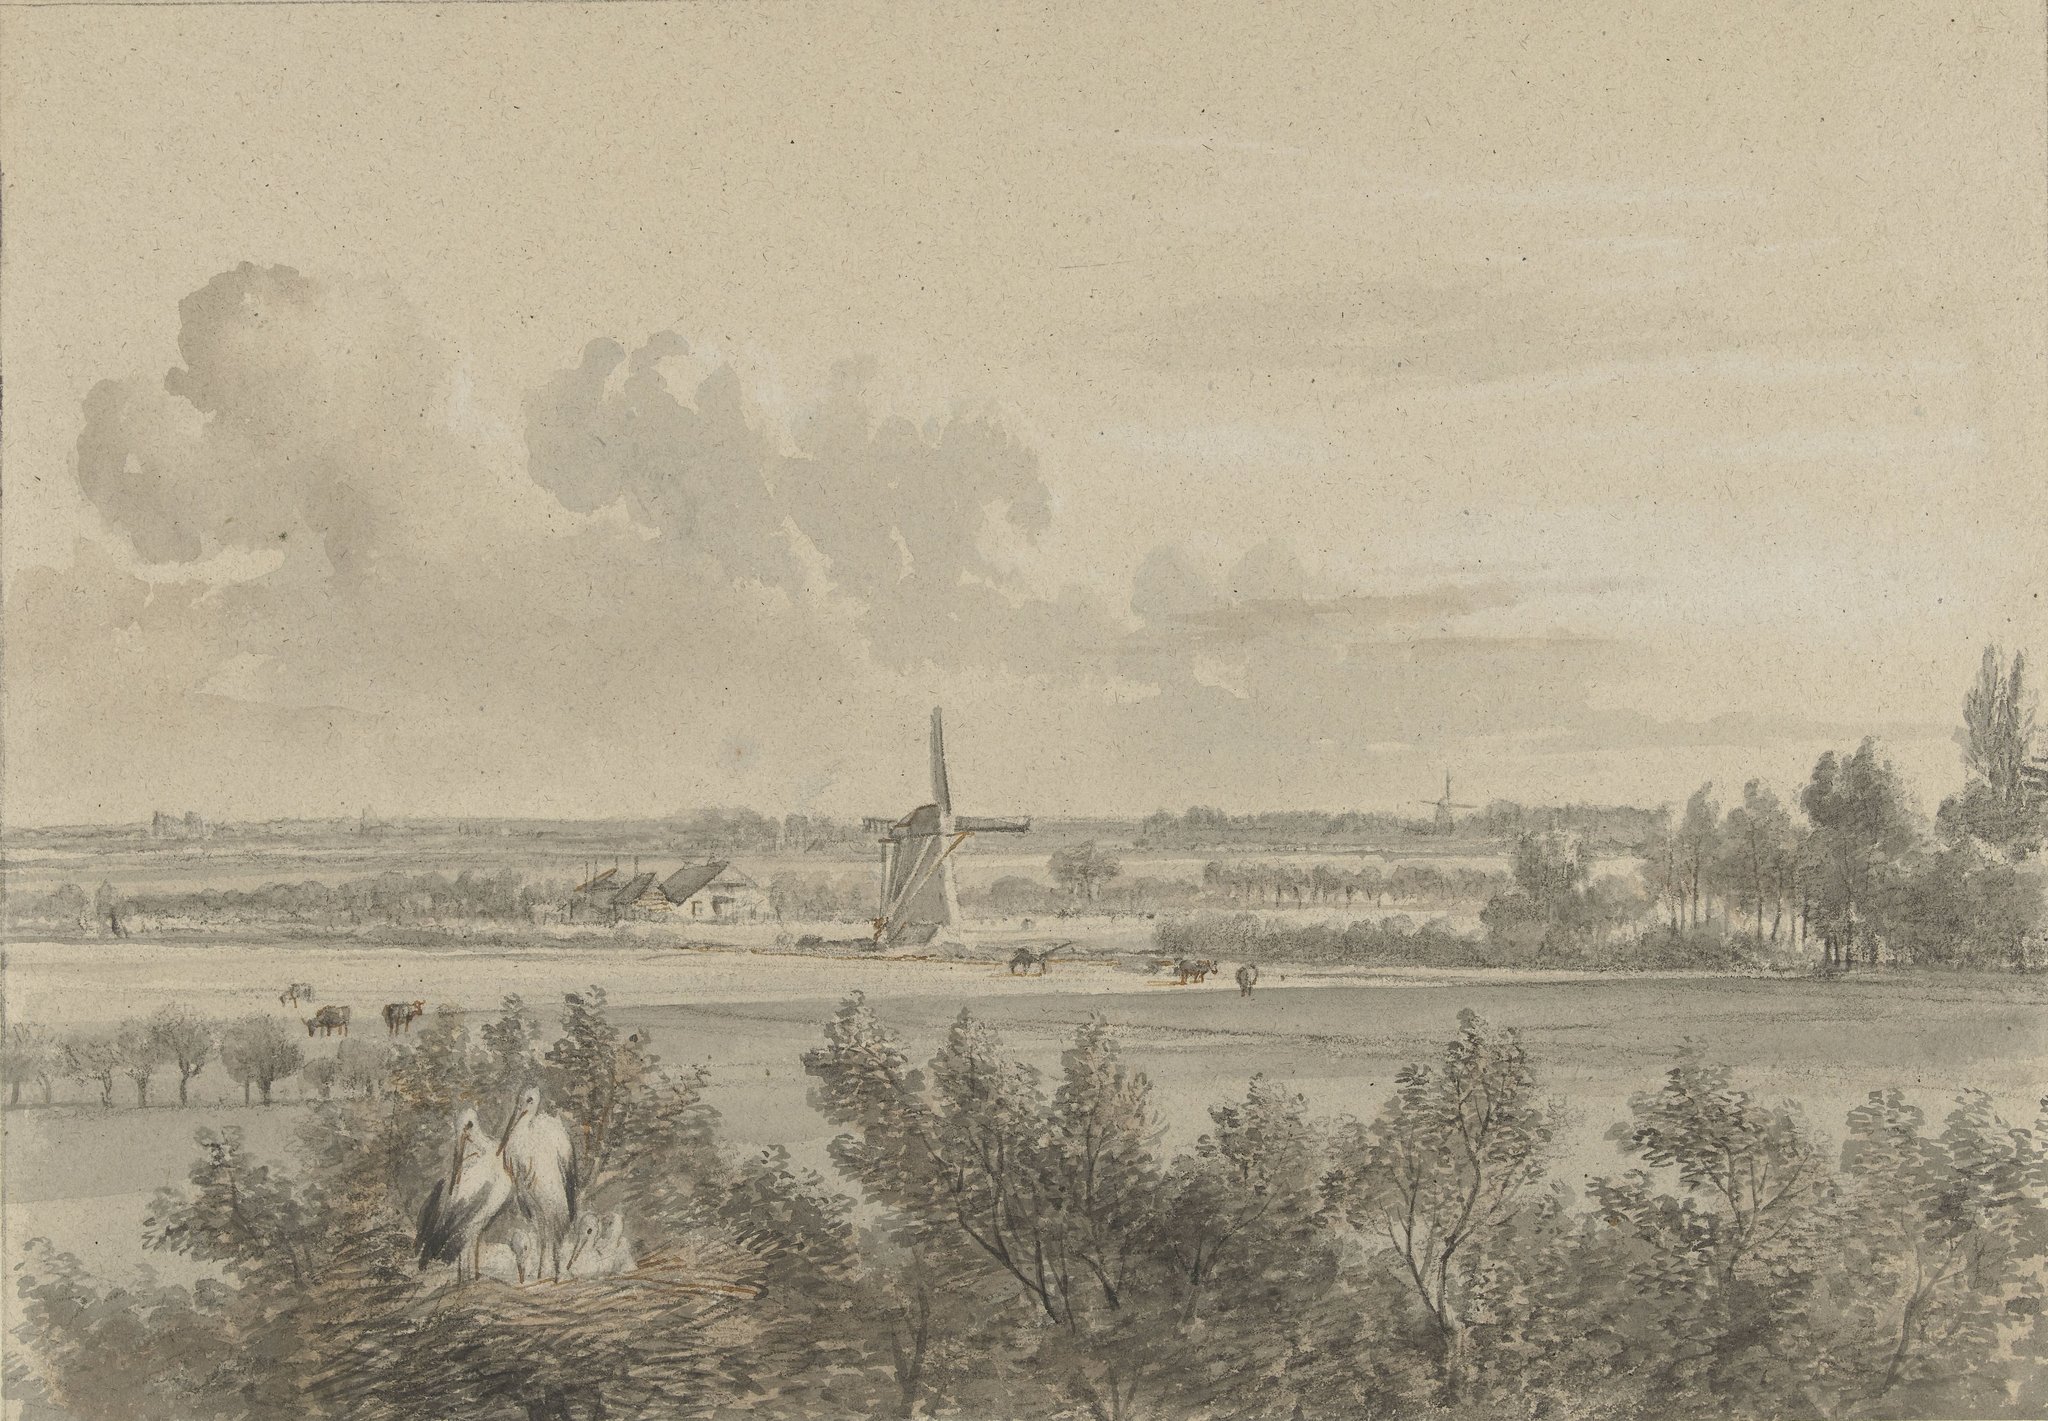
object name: drawing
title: Landschap bij Maarssen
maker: jacobus theodorus abels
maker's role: draughtsman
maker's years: 1803-1866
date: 1813-1866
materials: chalk, ink, paper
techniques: brush, pen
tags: windmill in landscape, maarssen